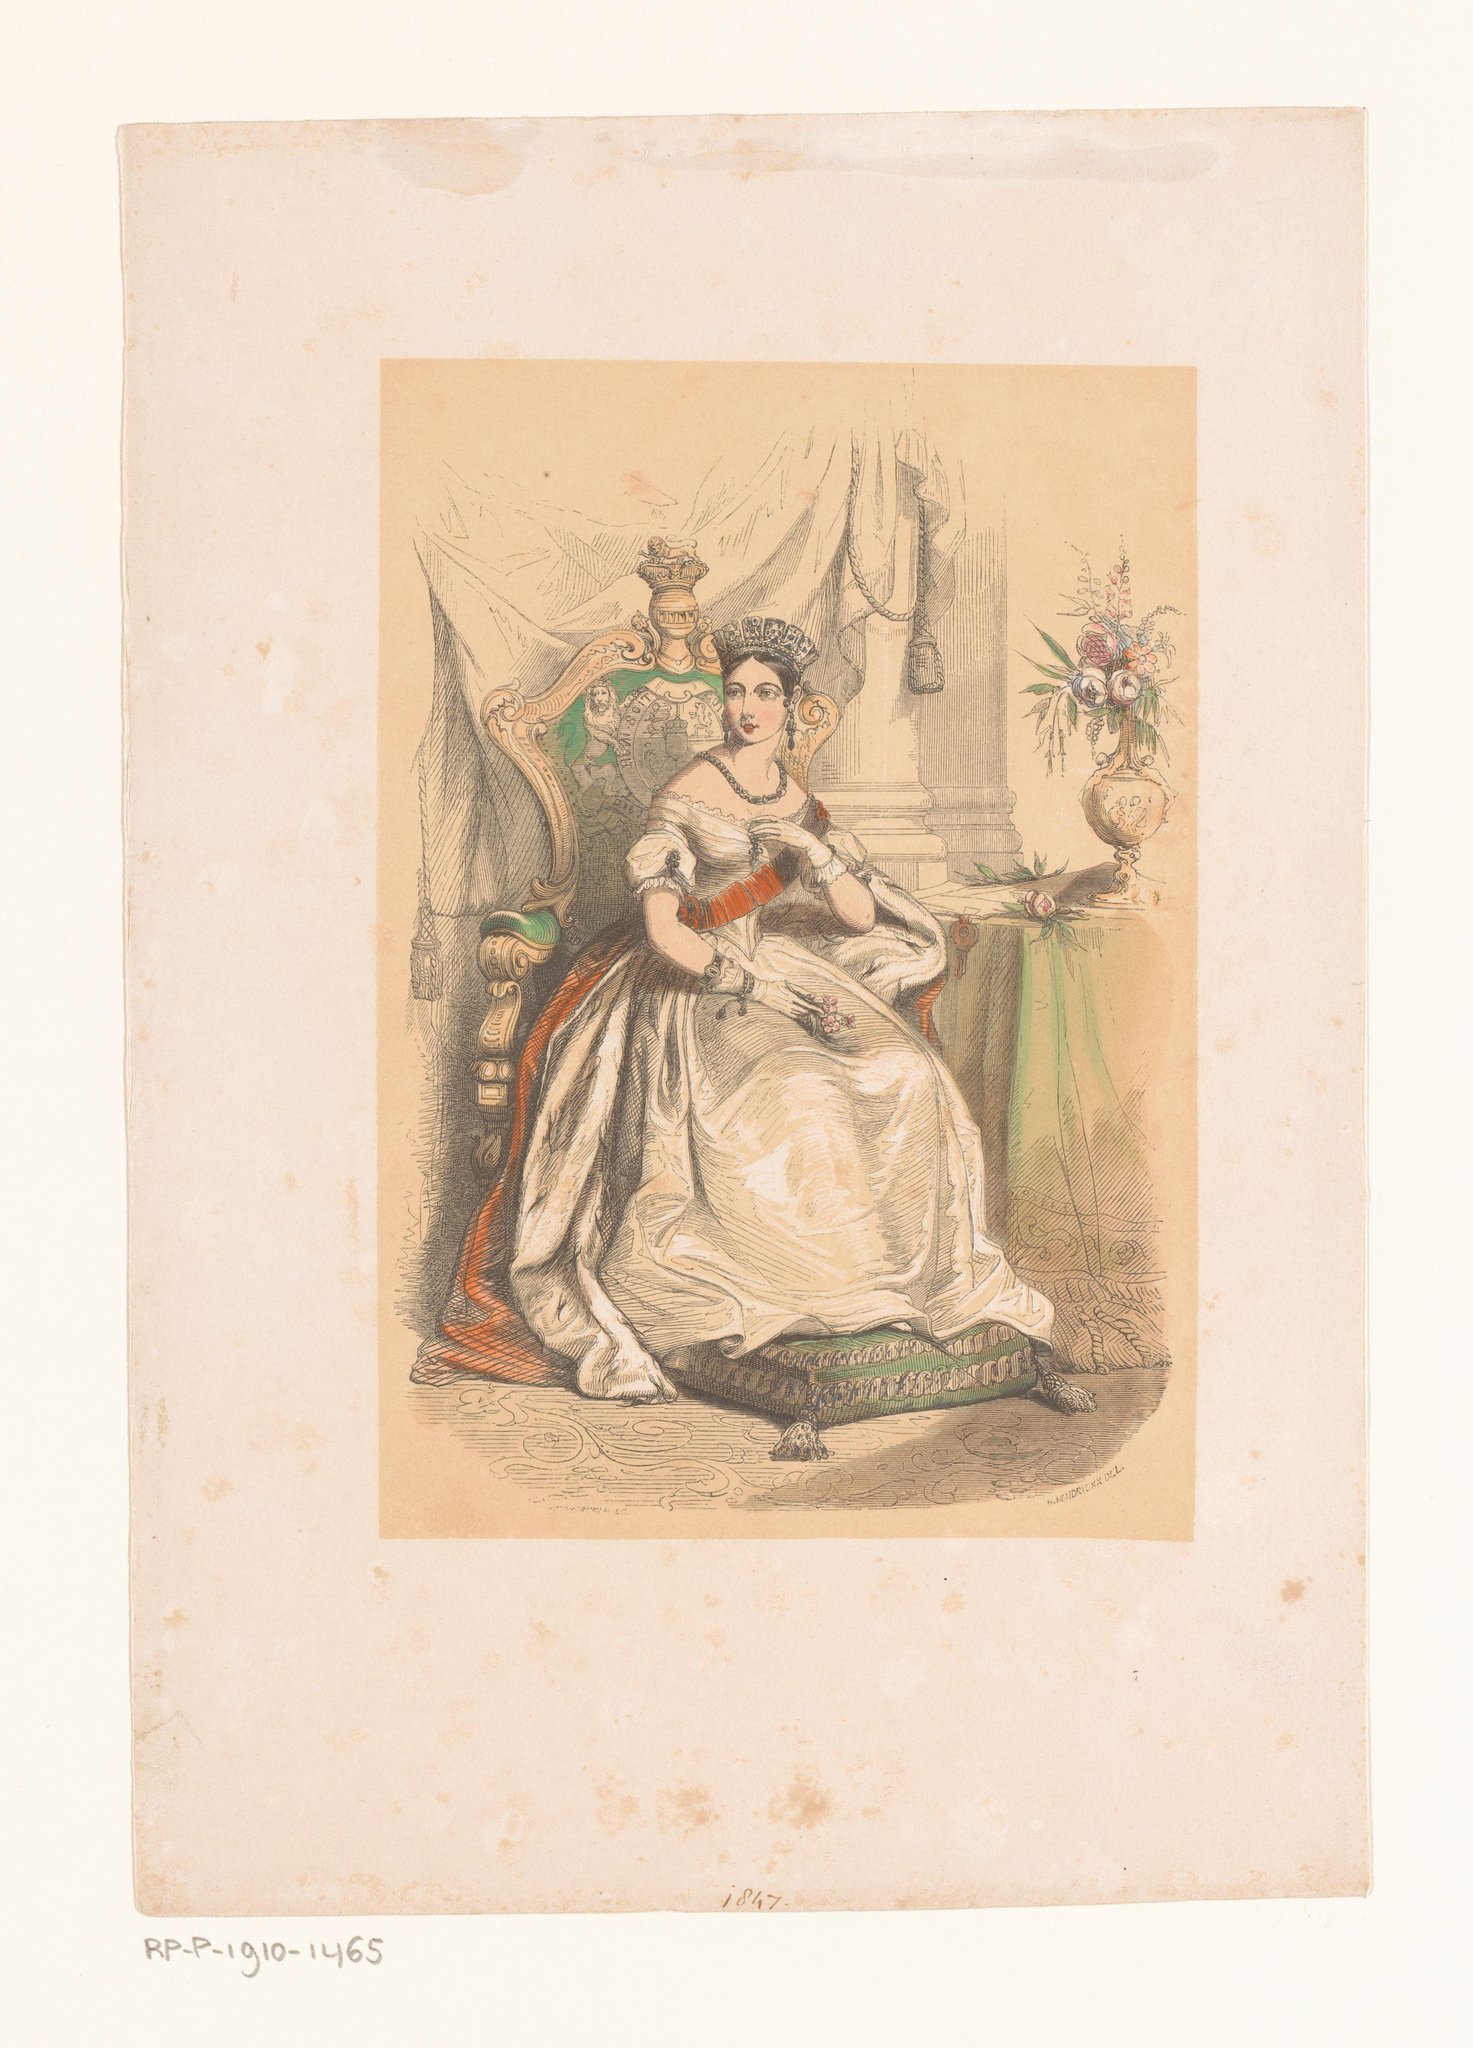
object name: print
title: Portret van koningin Victoria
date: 1830-1906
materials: paper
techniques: hand coloring, engraving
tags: victoria (koningin van het verenigd koninkrijk en keizerin van india), historical persons, queen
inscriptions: inscription: ‘1847.’, collector's mark: Lugt 2228